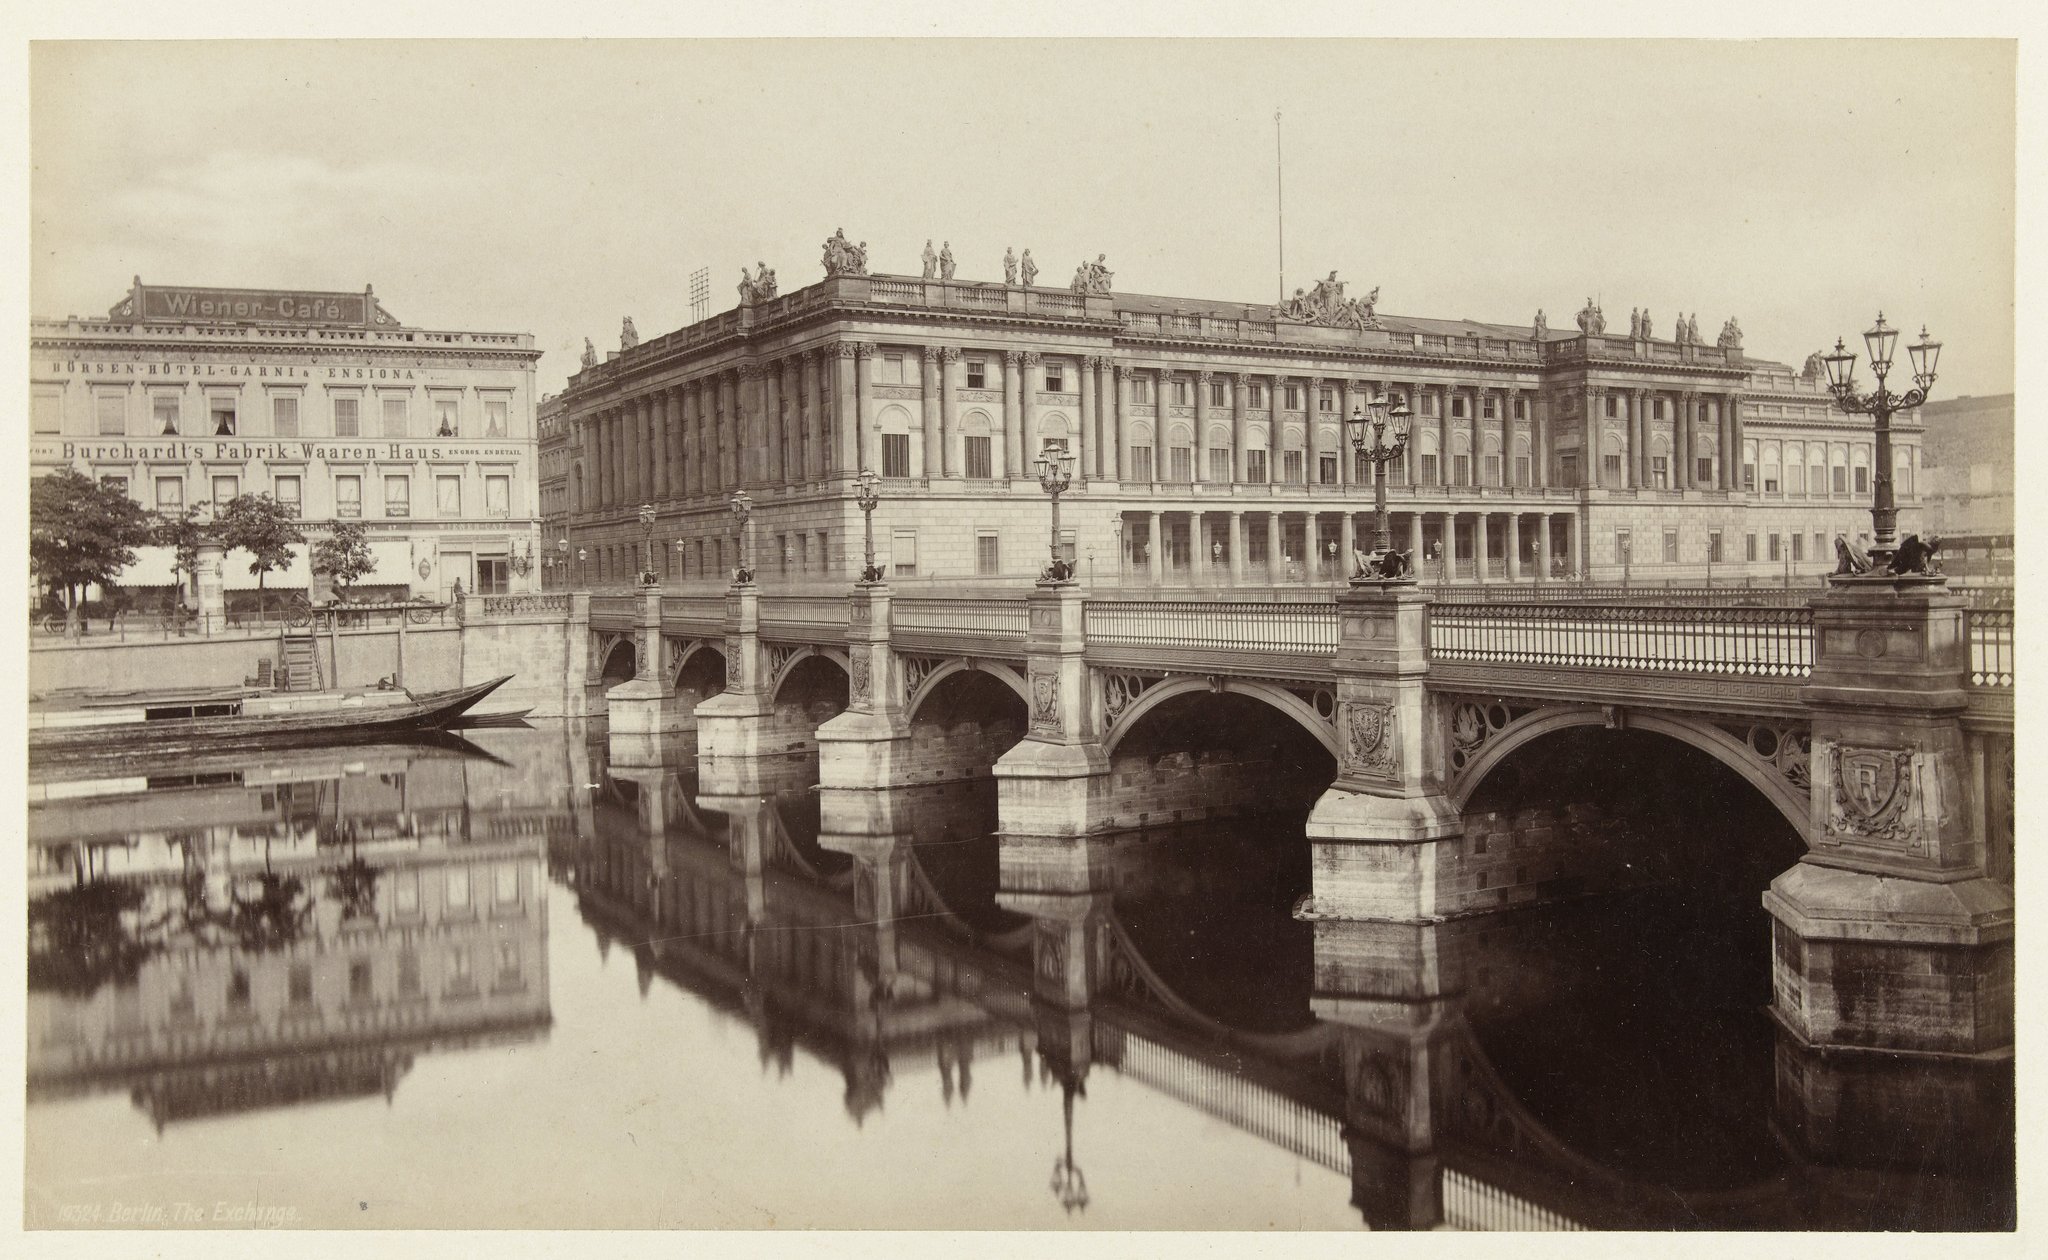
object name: photograph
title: Friedrichsbrücke over de Spree in Berlijn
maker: Anonymous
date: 1875-1884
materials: cardboard, paper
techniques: albumen print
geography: reigate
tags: bridge in city across river, canal, etc.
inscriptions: number: ‘19324.’